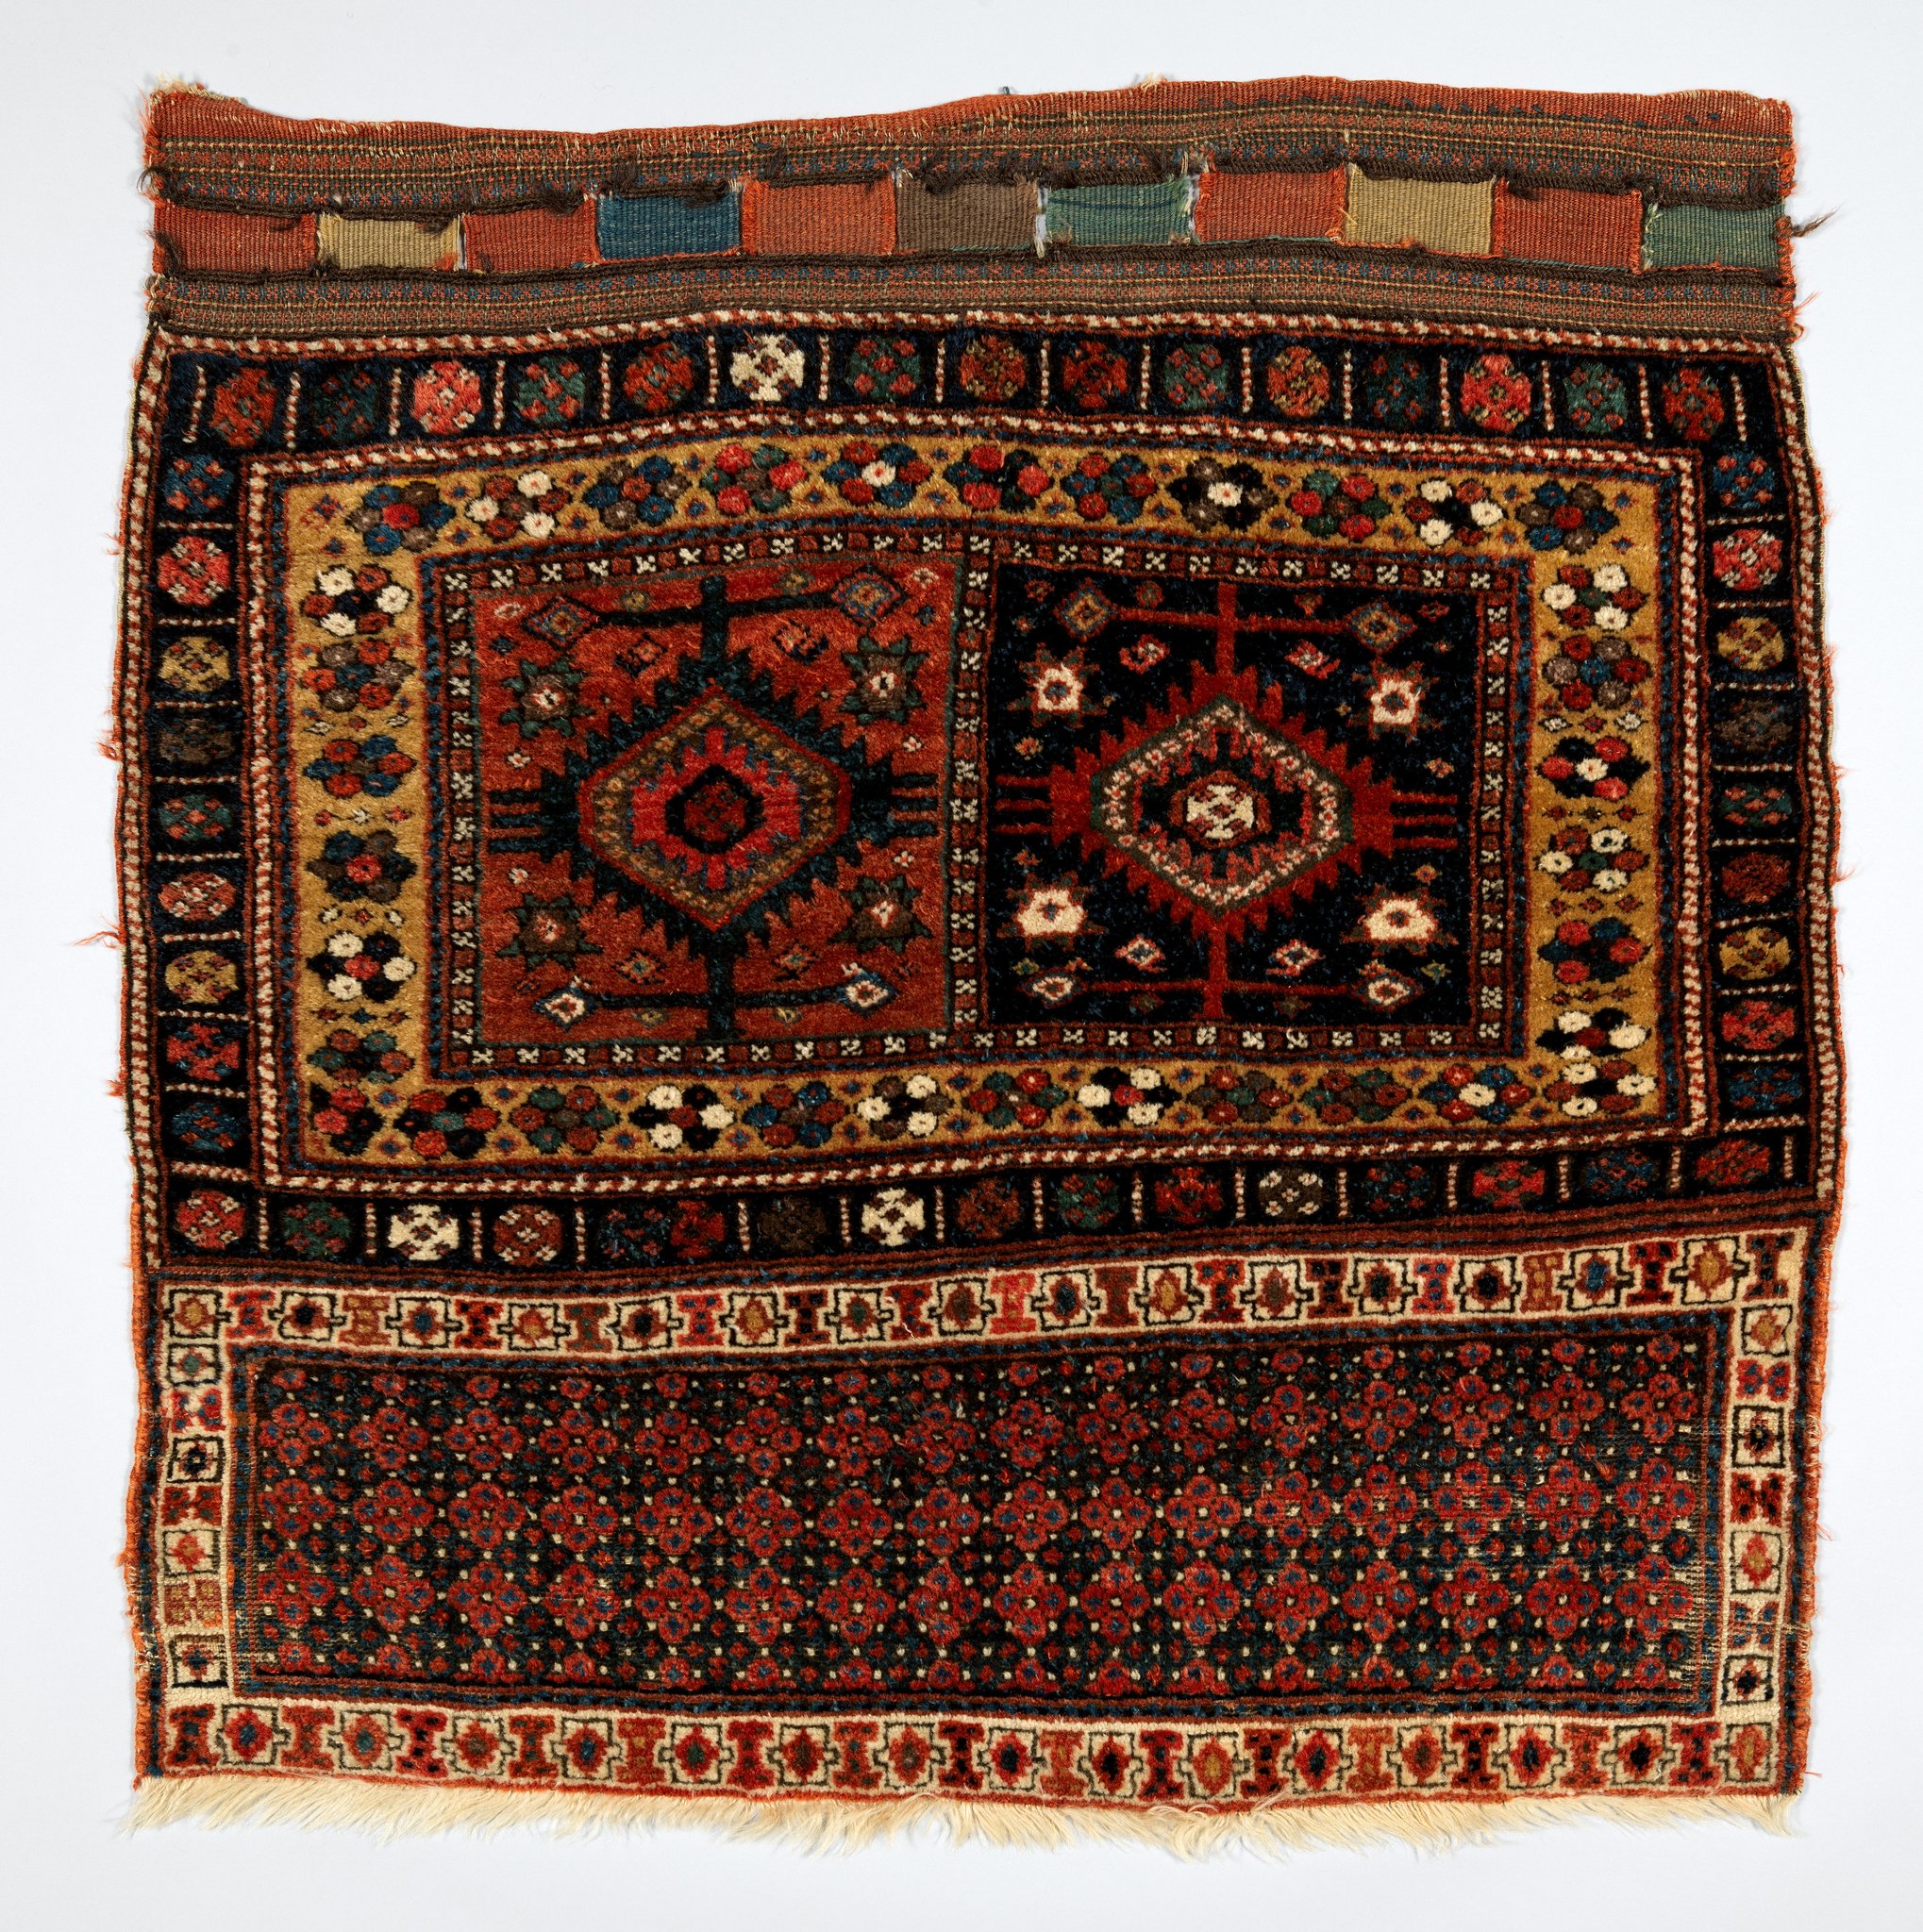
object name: bag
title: Face from a Large Bag (Chuval)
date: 1860-1870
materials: wool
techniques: asymmetrically knotted pile, weave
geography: iran